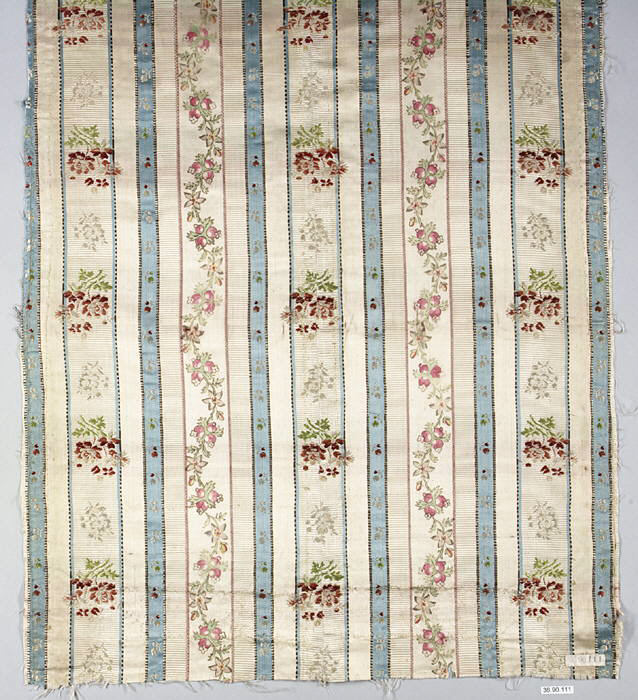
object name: piece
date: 1780-1790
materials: silk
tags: flowers